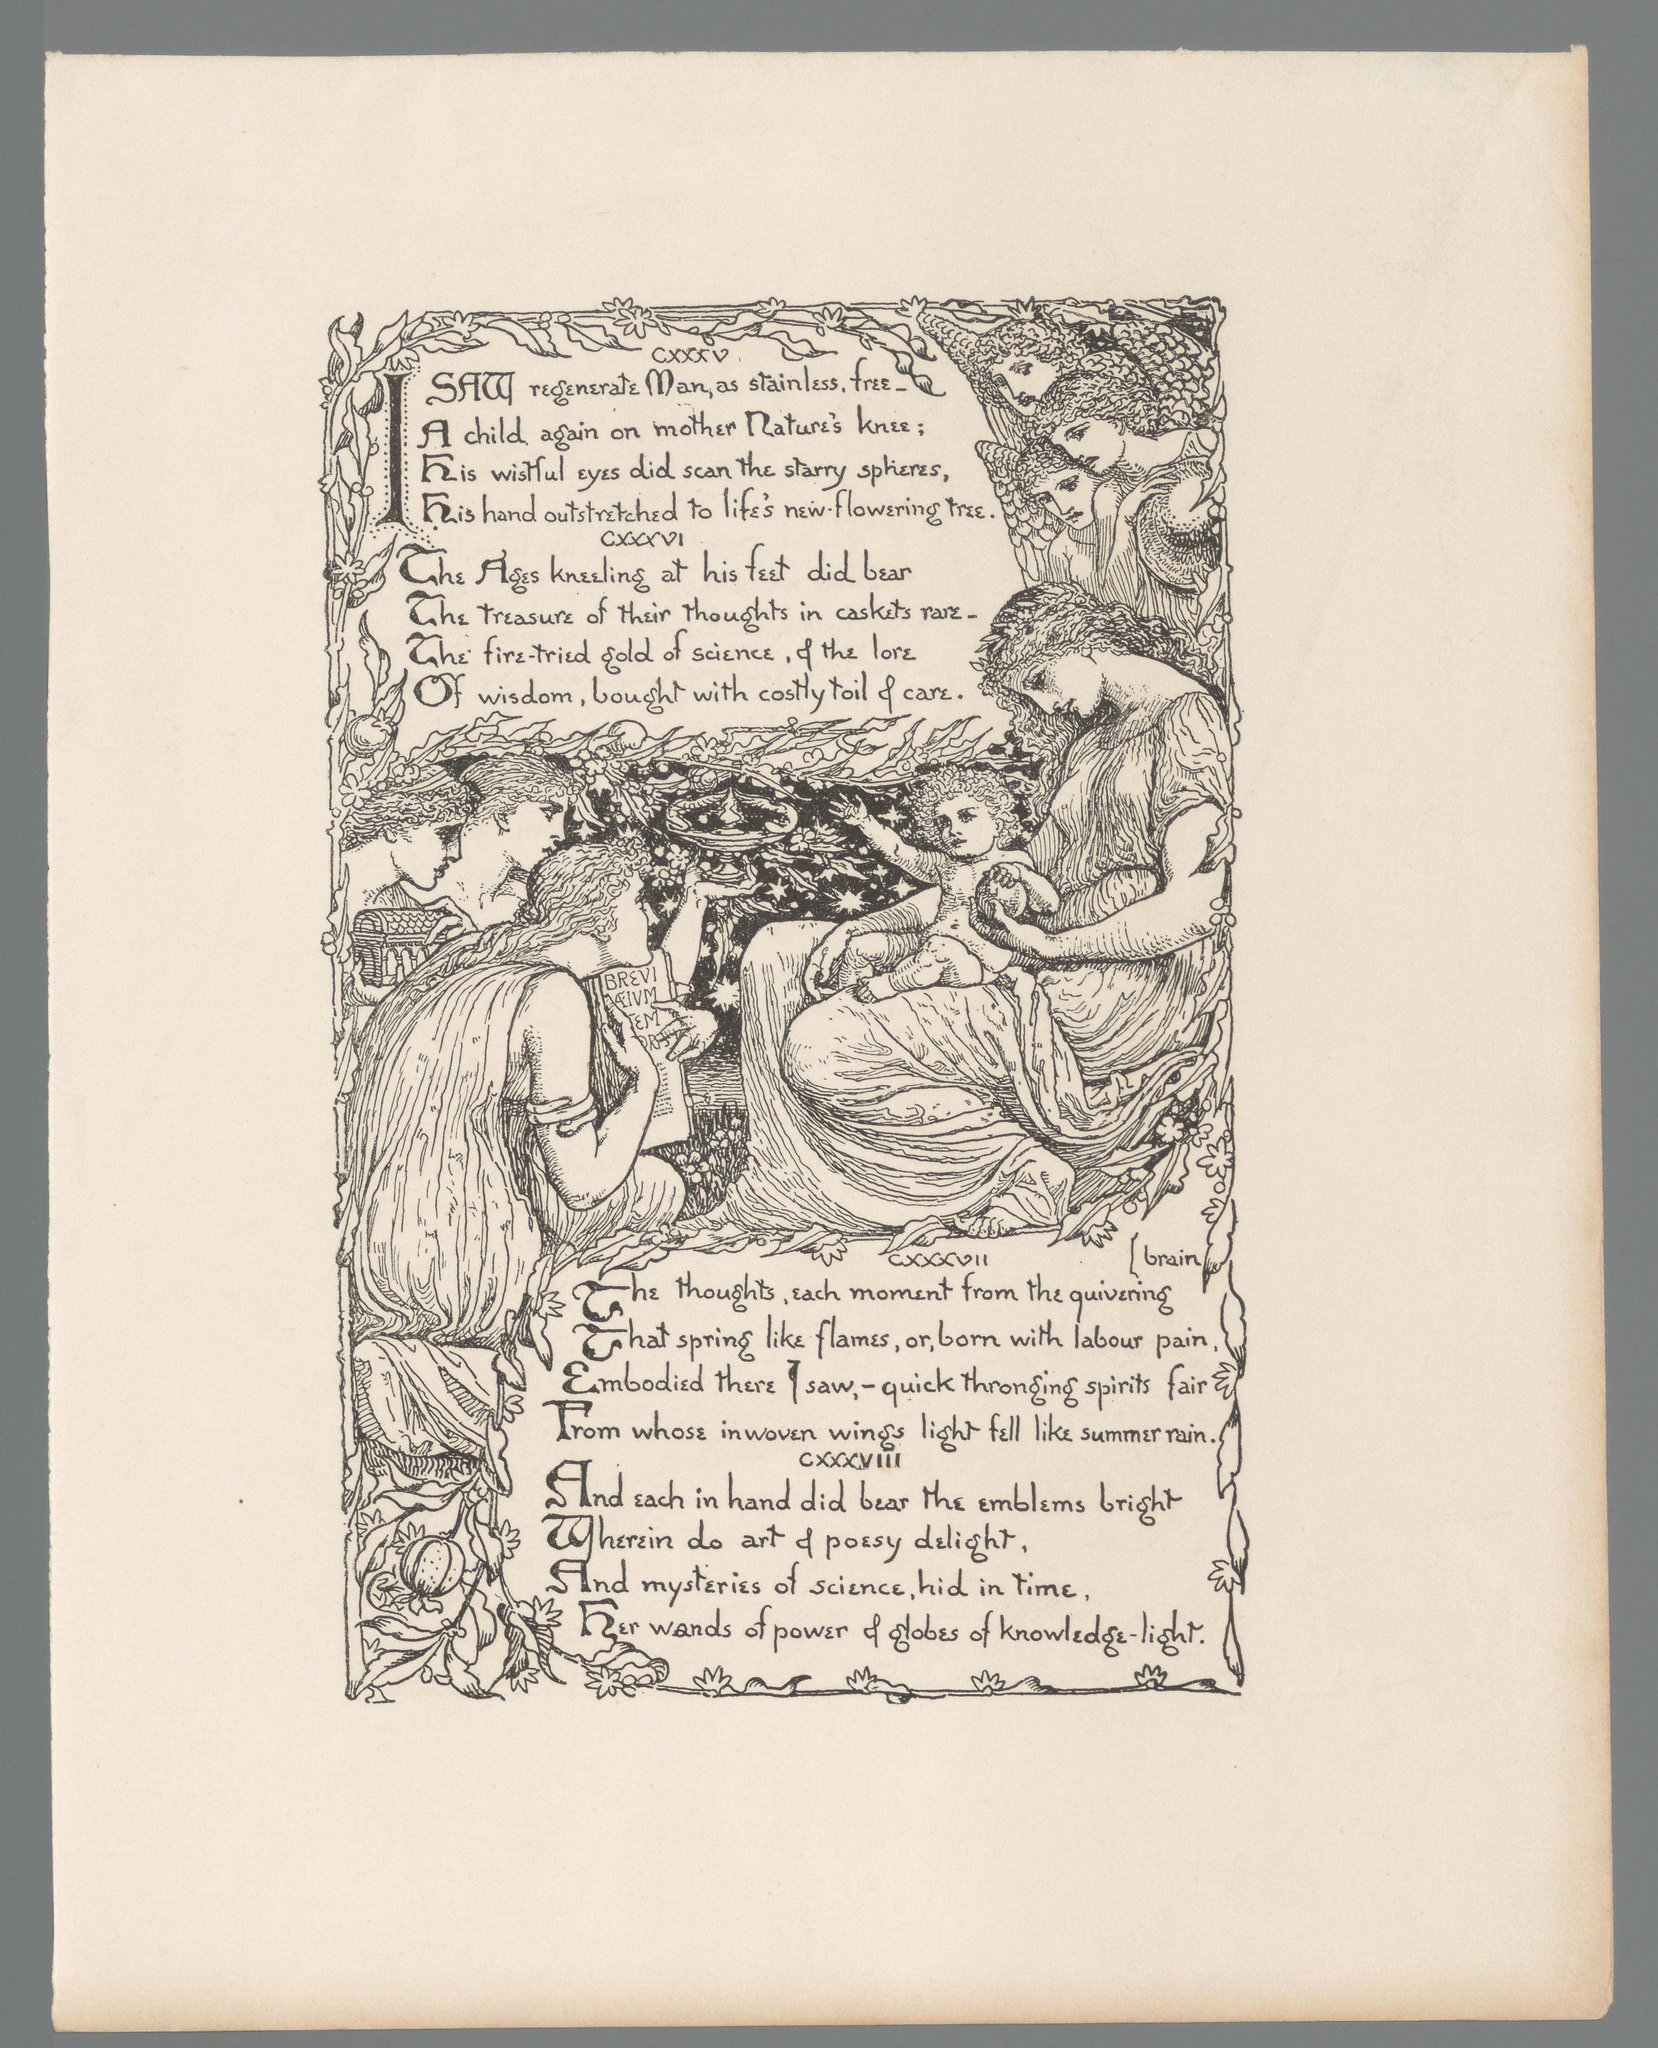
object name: book illustration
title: Cartouche met figuren die geschenken brengen aan een kind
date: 1886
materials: paper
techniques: engraving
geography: london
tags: mother and baby or young child, bringing gifts; exchanging gifts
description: Prent uit: Crane, Walter. The sirens three. Londen: Macmillan & Co., 1886.